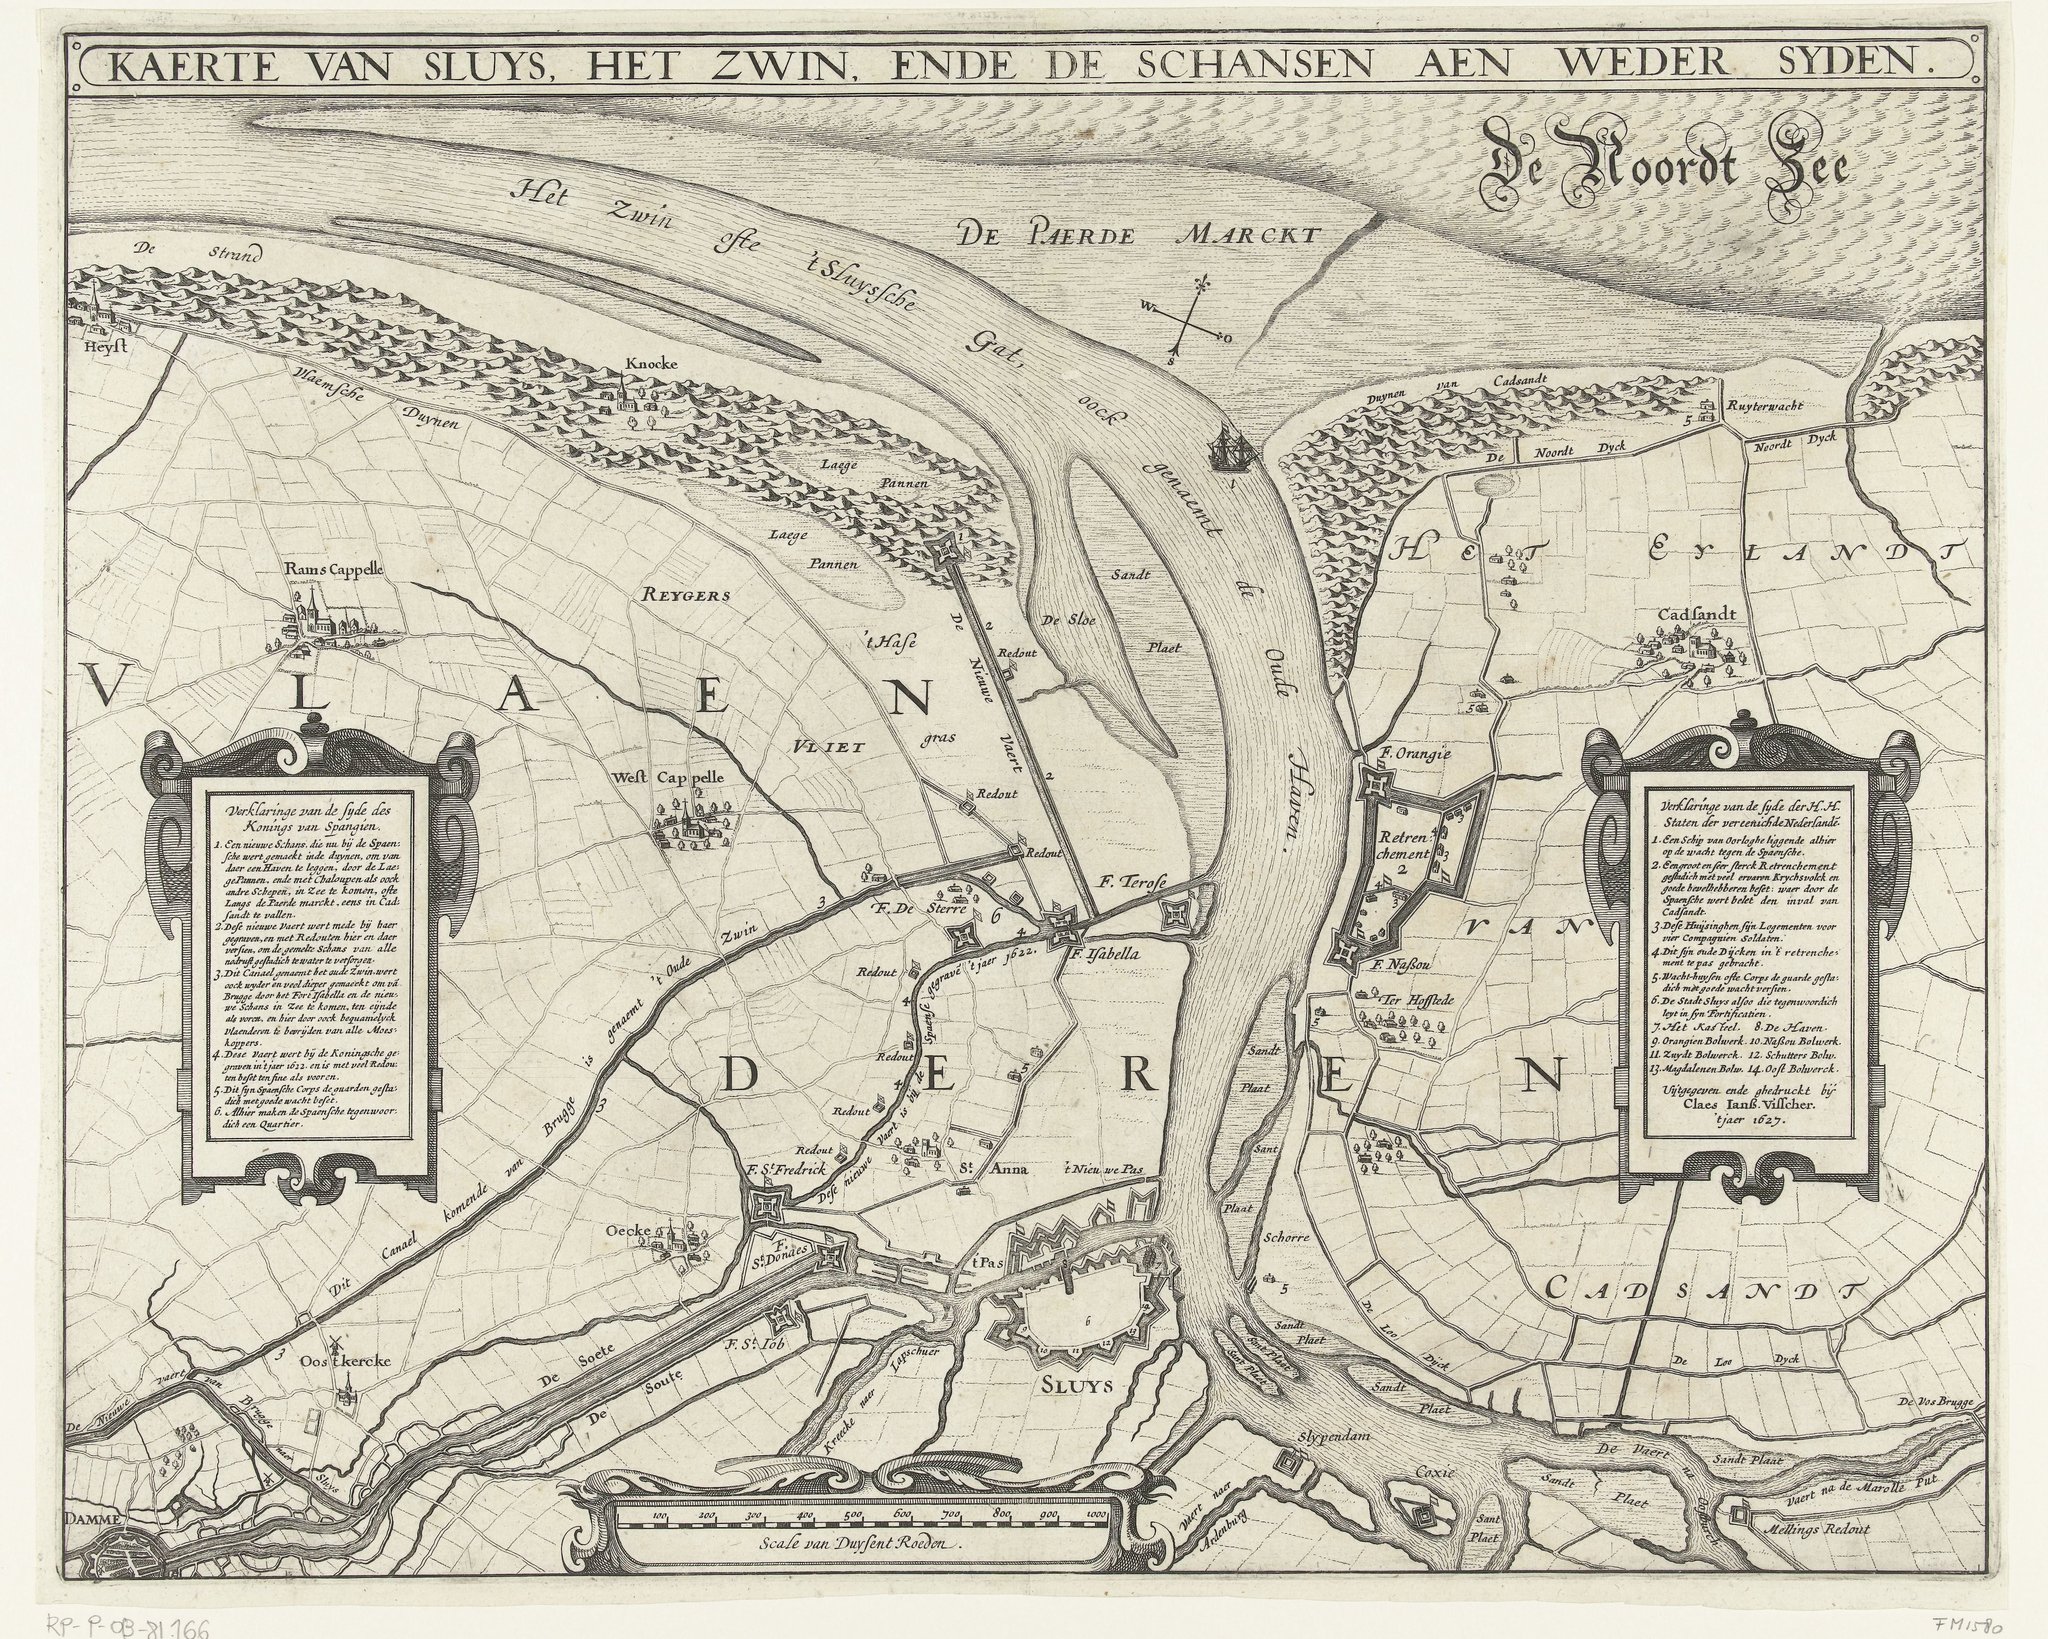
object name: map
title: Kaerte van Sluys, het Zwin, ende de schansen aen weder syden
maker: claes jansz. visscher (ii)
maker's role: draughtsman, print maker, publisher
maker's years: 1586-1652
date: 1627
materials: paper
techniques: engraving, etching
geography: amsterdam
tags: maps of separate countries or regions, fortified city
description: Kaart van de stad Sluis met het Zwin, het omliggende land tussen Cadzand, Damme en Ramskapelle; met de schansen aan Spaanse en Staatse zijde, 1627. Links en rechts cartouches met de legenda's 1-6 en 1-13 in het Nederlands. Onder, links van het midden, een schaalstok: Scale van Duysent Roeden.